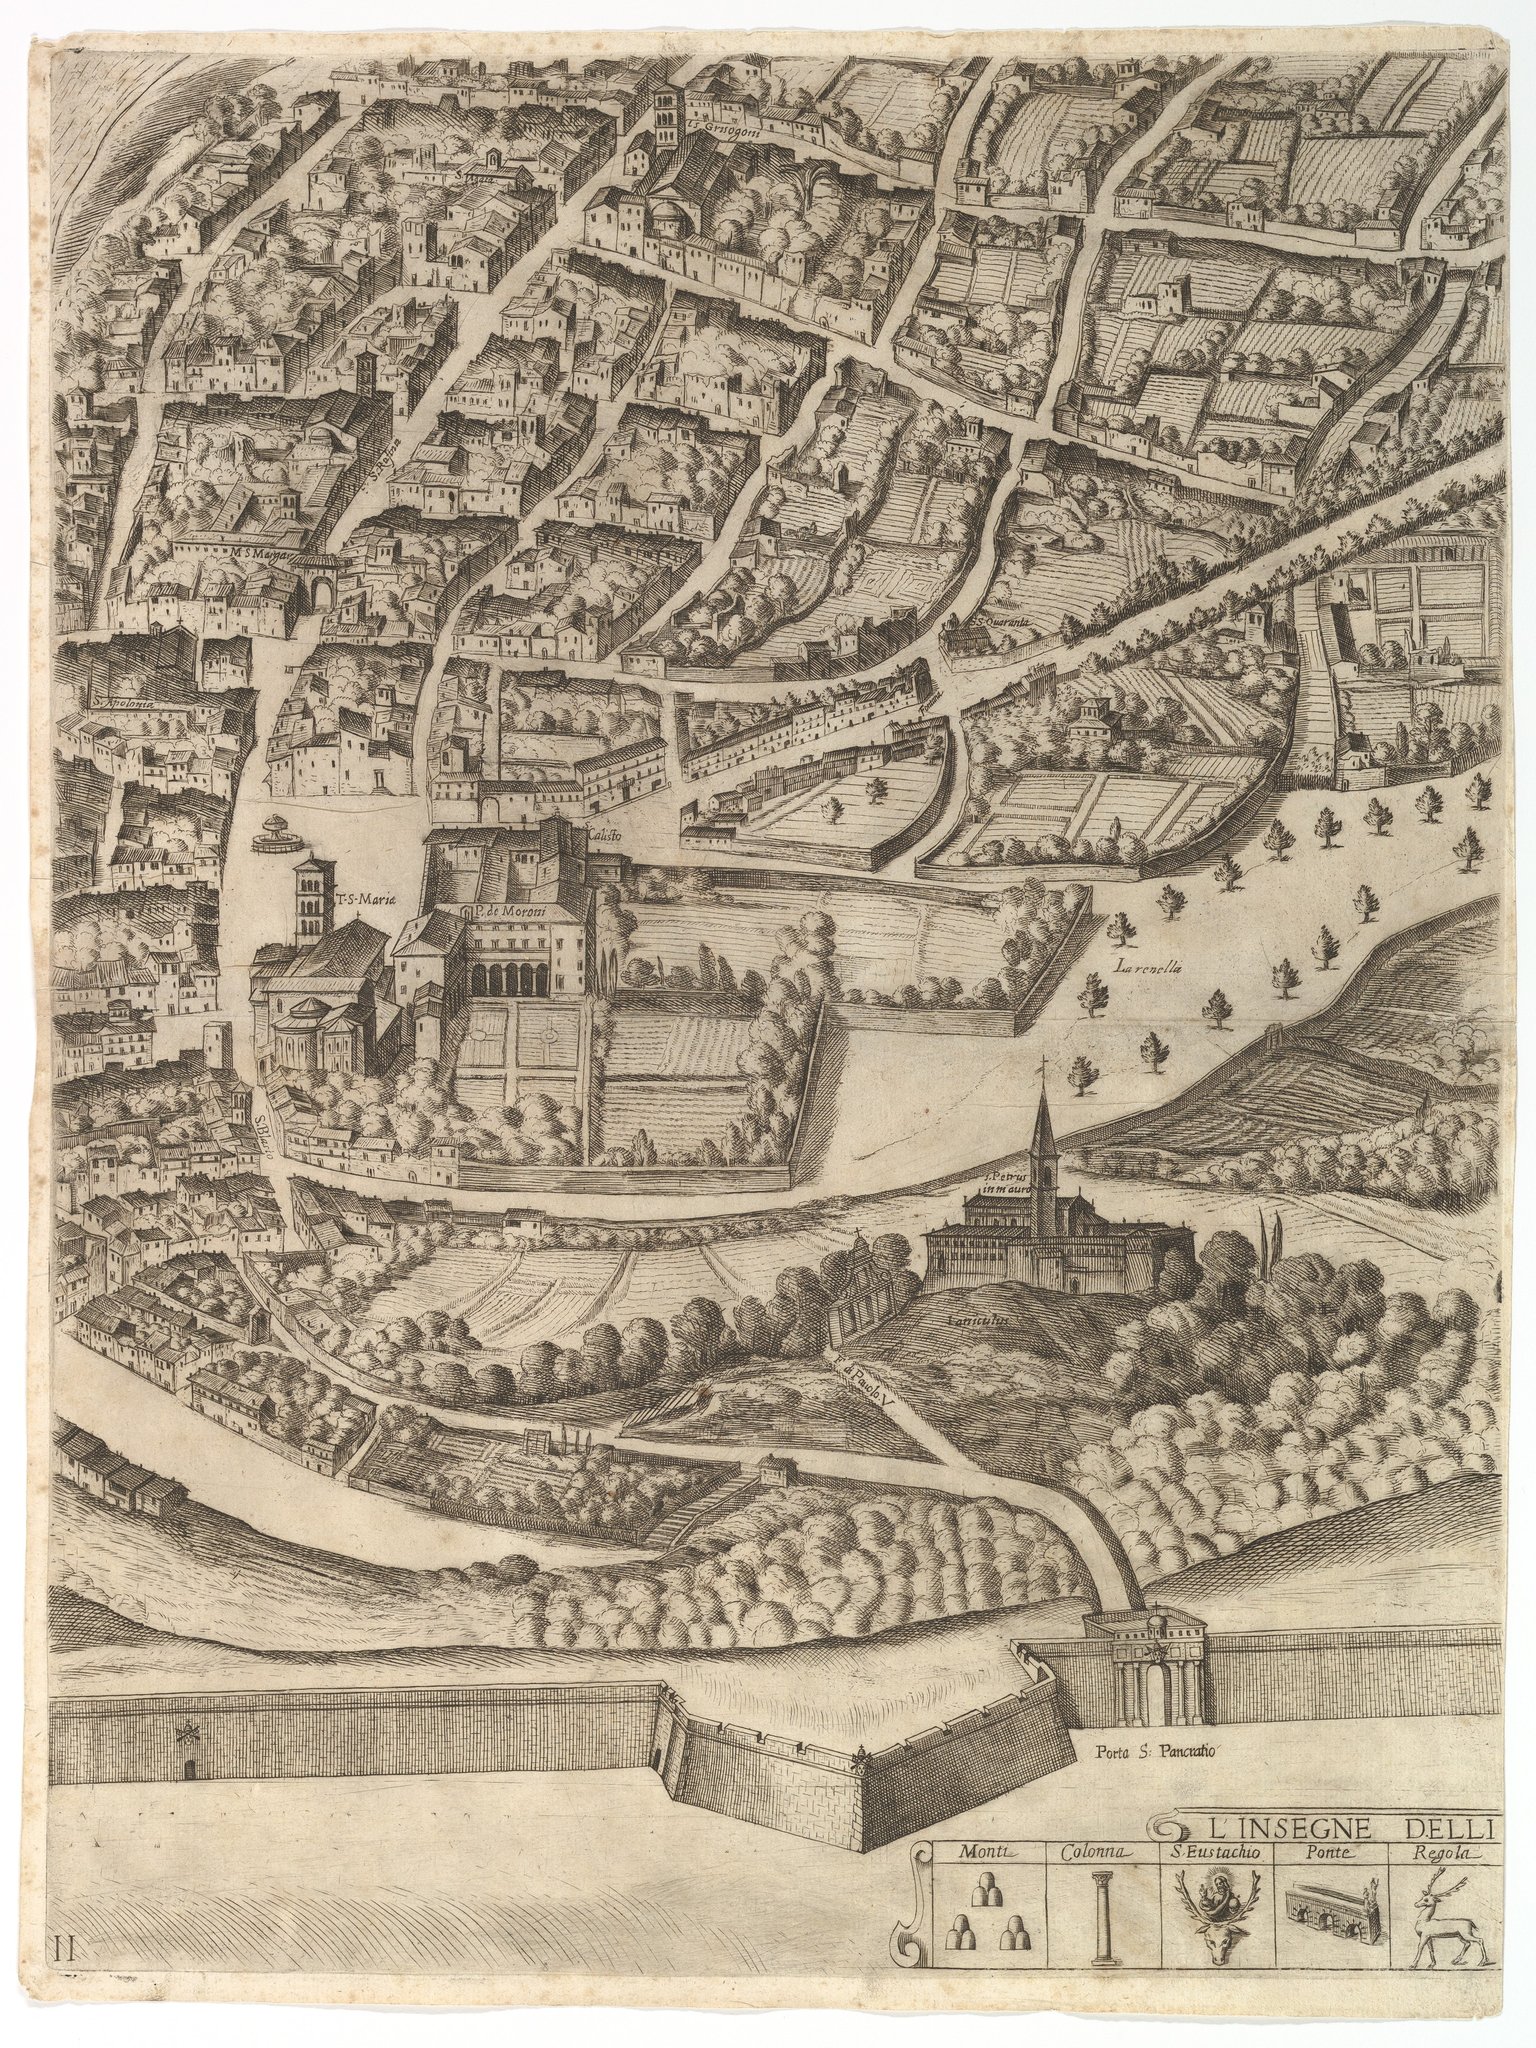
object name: print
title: Plan of the City of Rome. Part 11 with the San Pancrazio (left bank)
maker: antonio tempesta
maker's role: artist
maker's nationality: italian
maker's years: 1555-1630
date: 1645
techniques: engraving, etching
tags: cities,rome